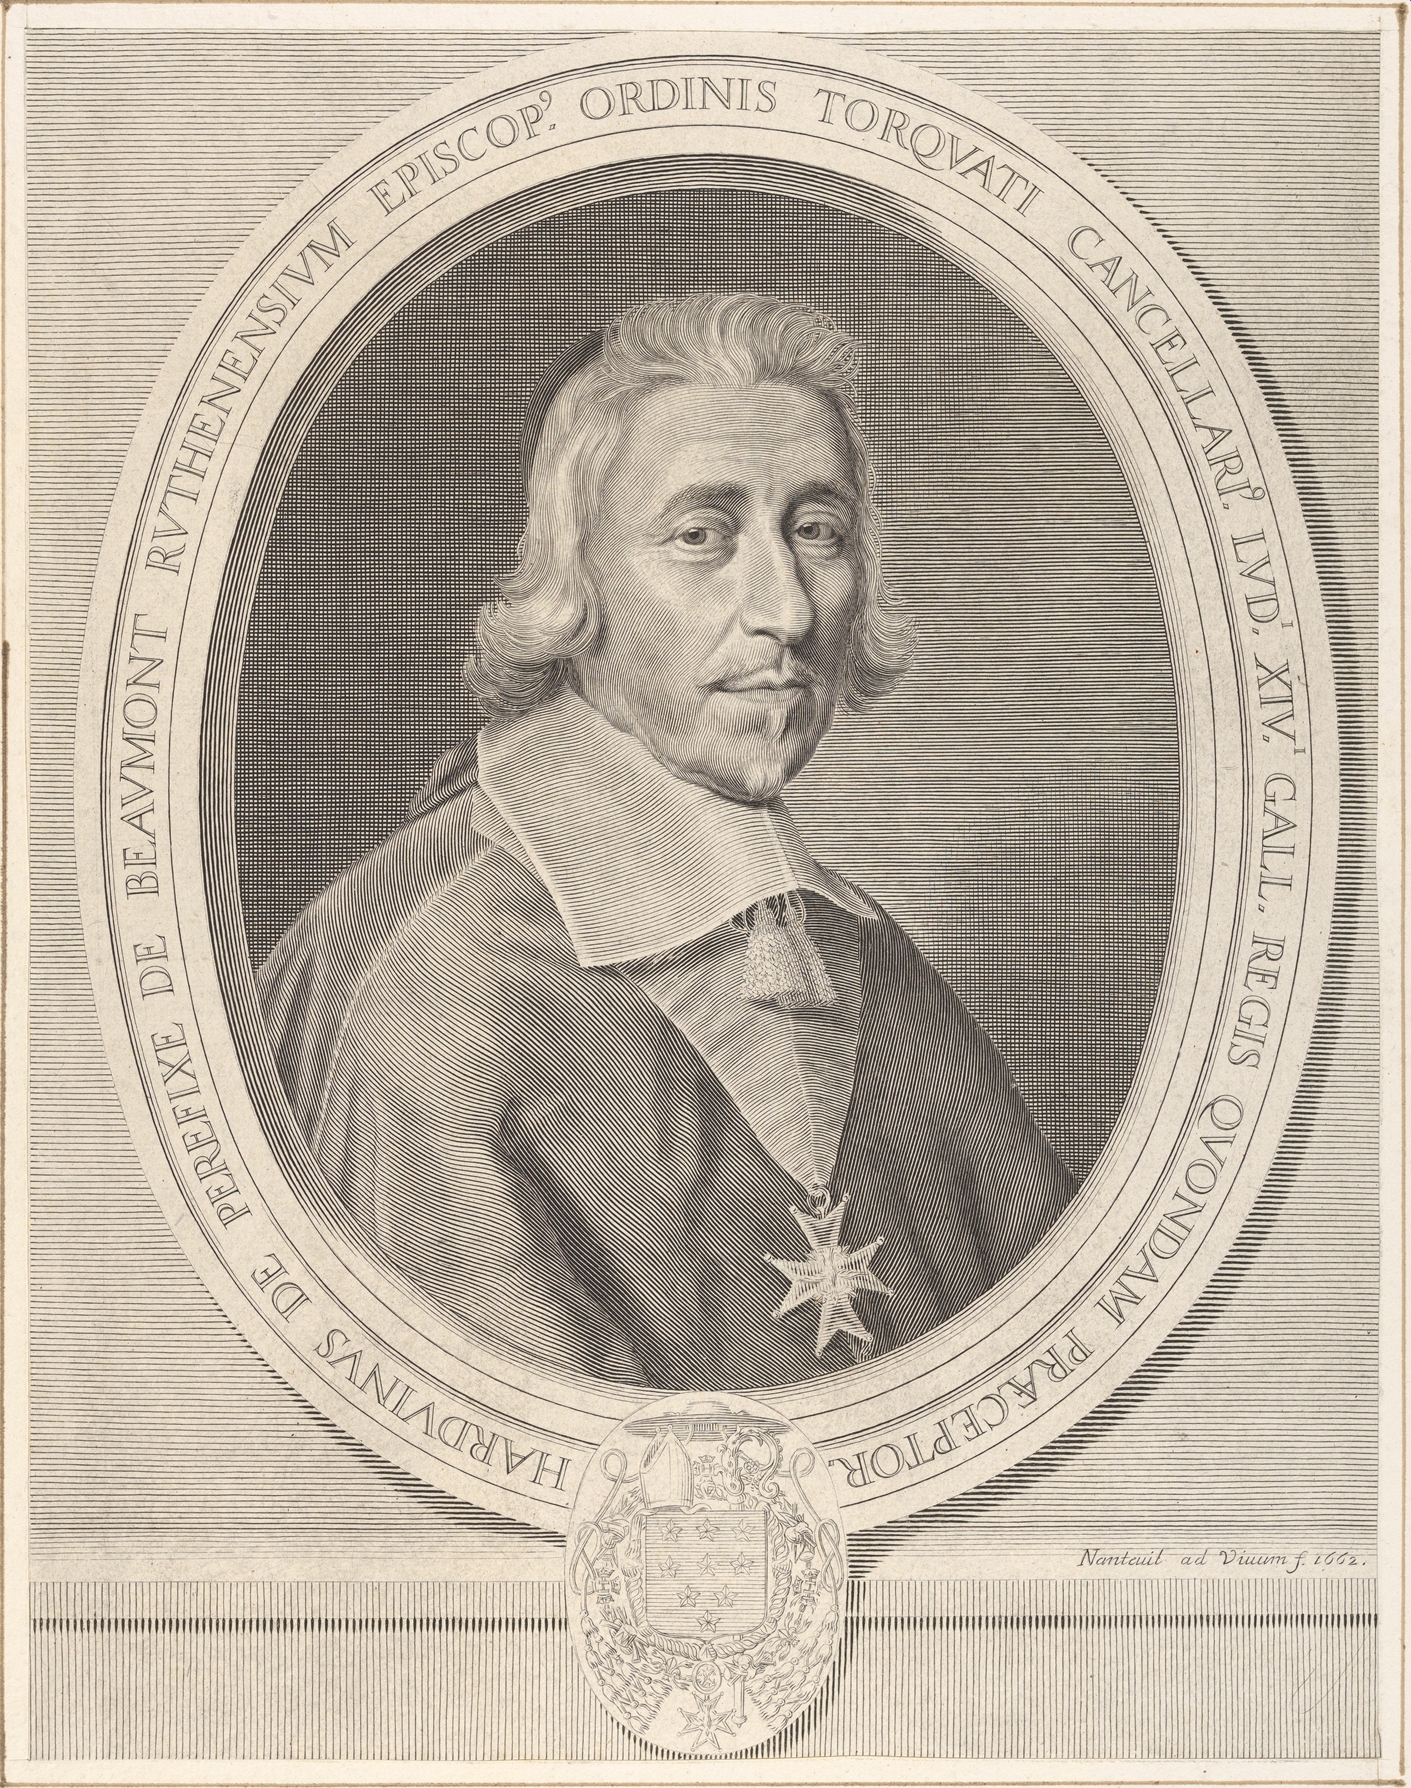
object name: print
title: Hardouin de Péréfixe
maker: robert nanteuil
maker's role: artist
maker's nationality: french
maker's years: 1623-1678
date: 1662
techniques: engraving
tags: men,portraits,coat of arms